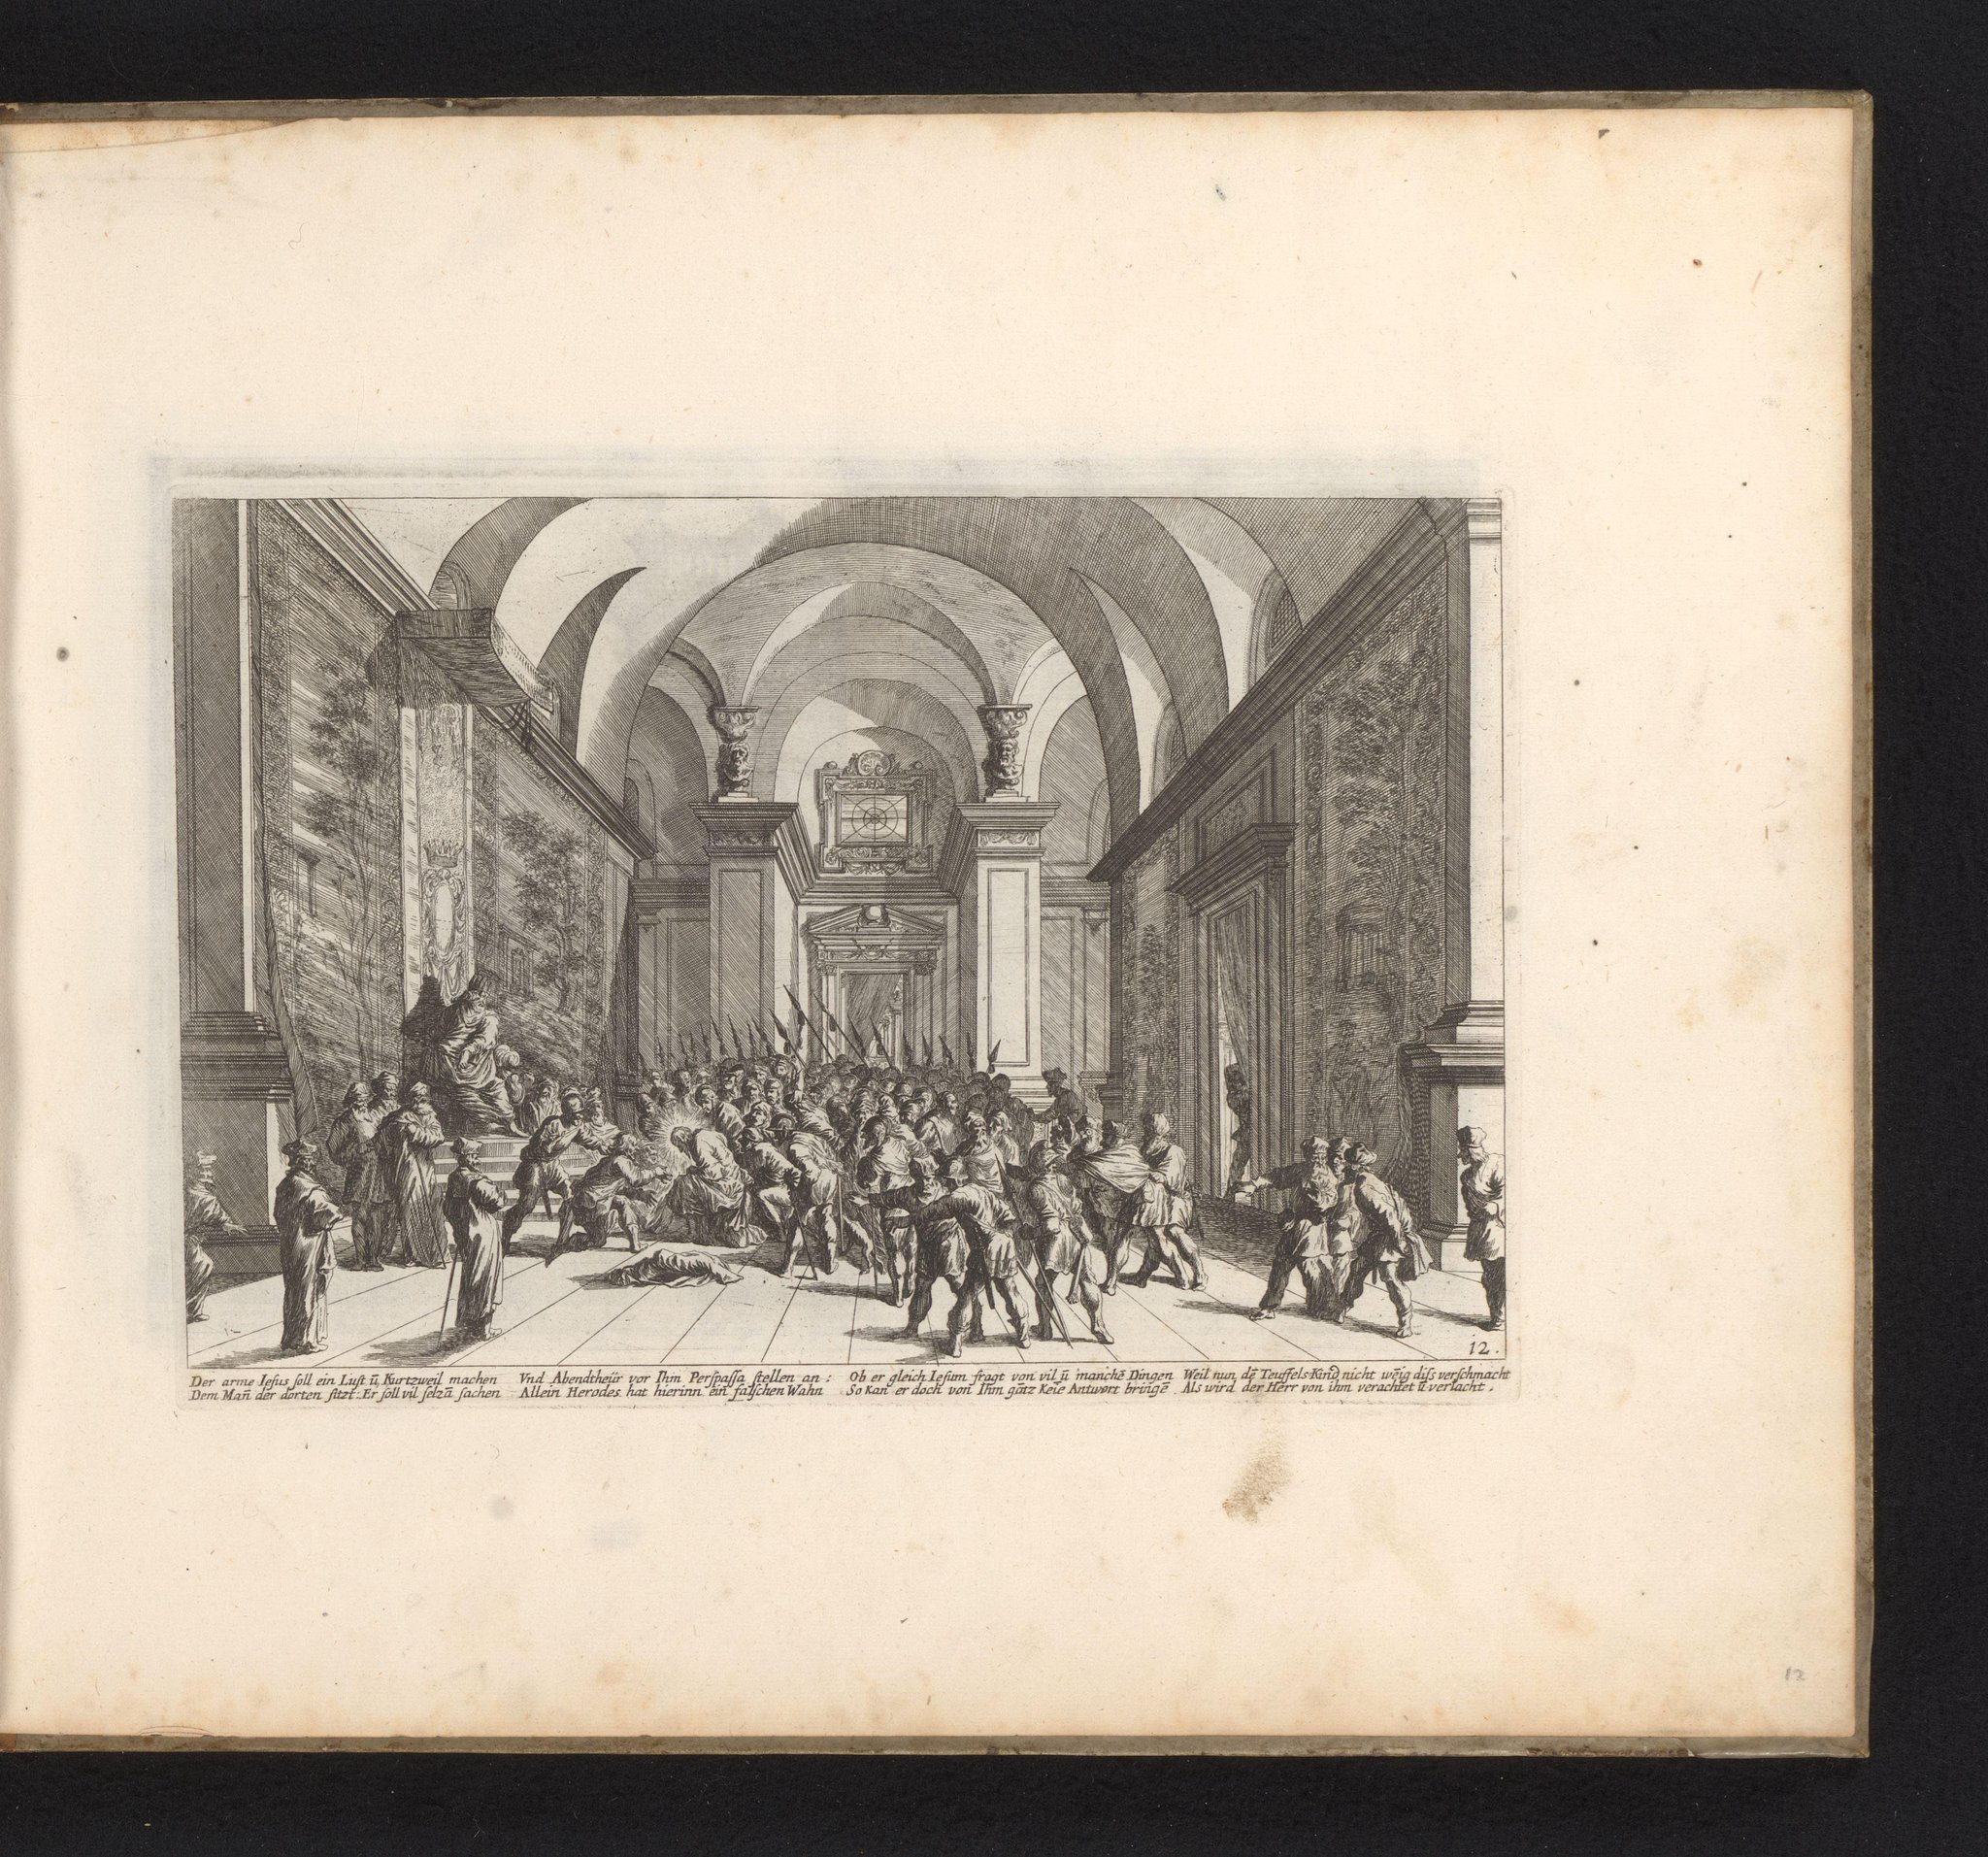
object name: print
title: Christus voor Herodes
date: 1670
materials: paper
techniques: etching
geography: augsburg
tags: christ before king herod; sometimes a gorgeous robe is brought (luke 23:8-11)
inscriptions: collector's mark: Lugt 2228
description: Tekst in het Duits in de ondermarge. Rechtsonder genummerd: 12. Prent maakt deel uit van een album.